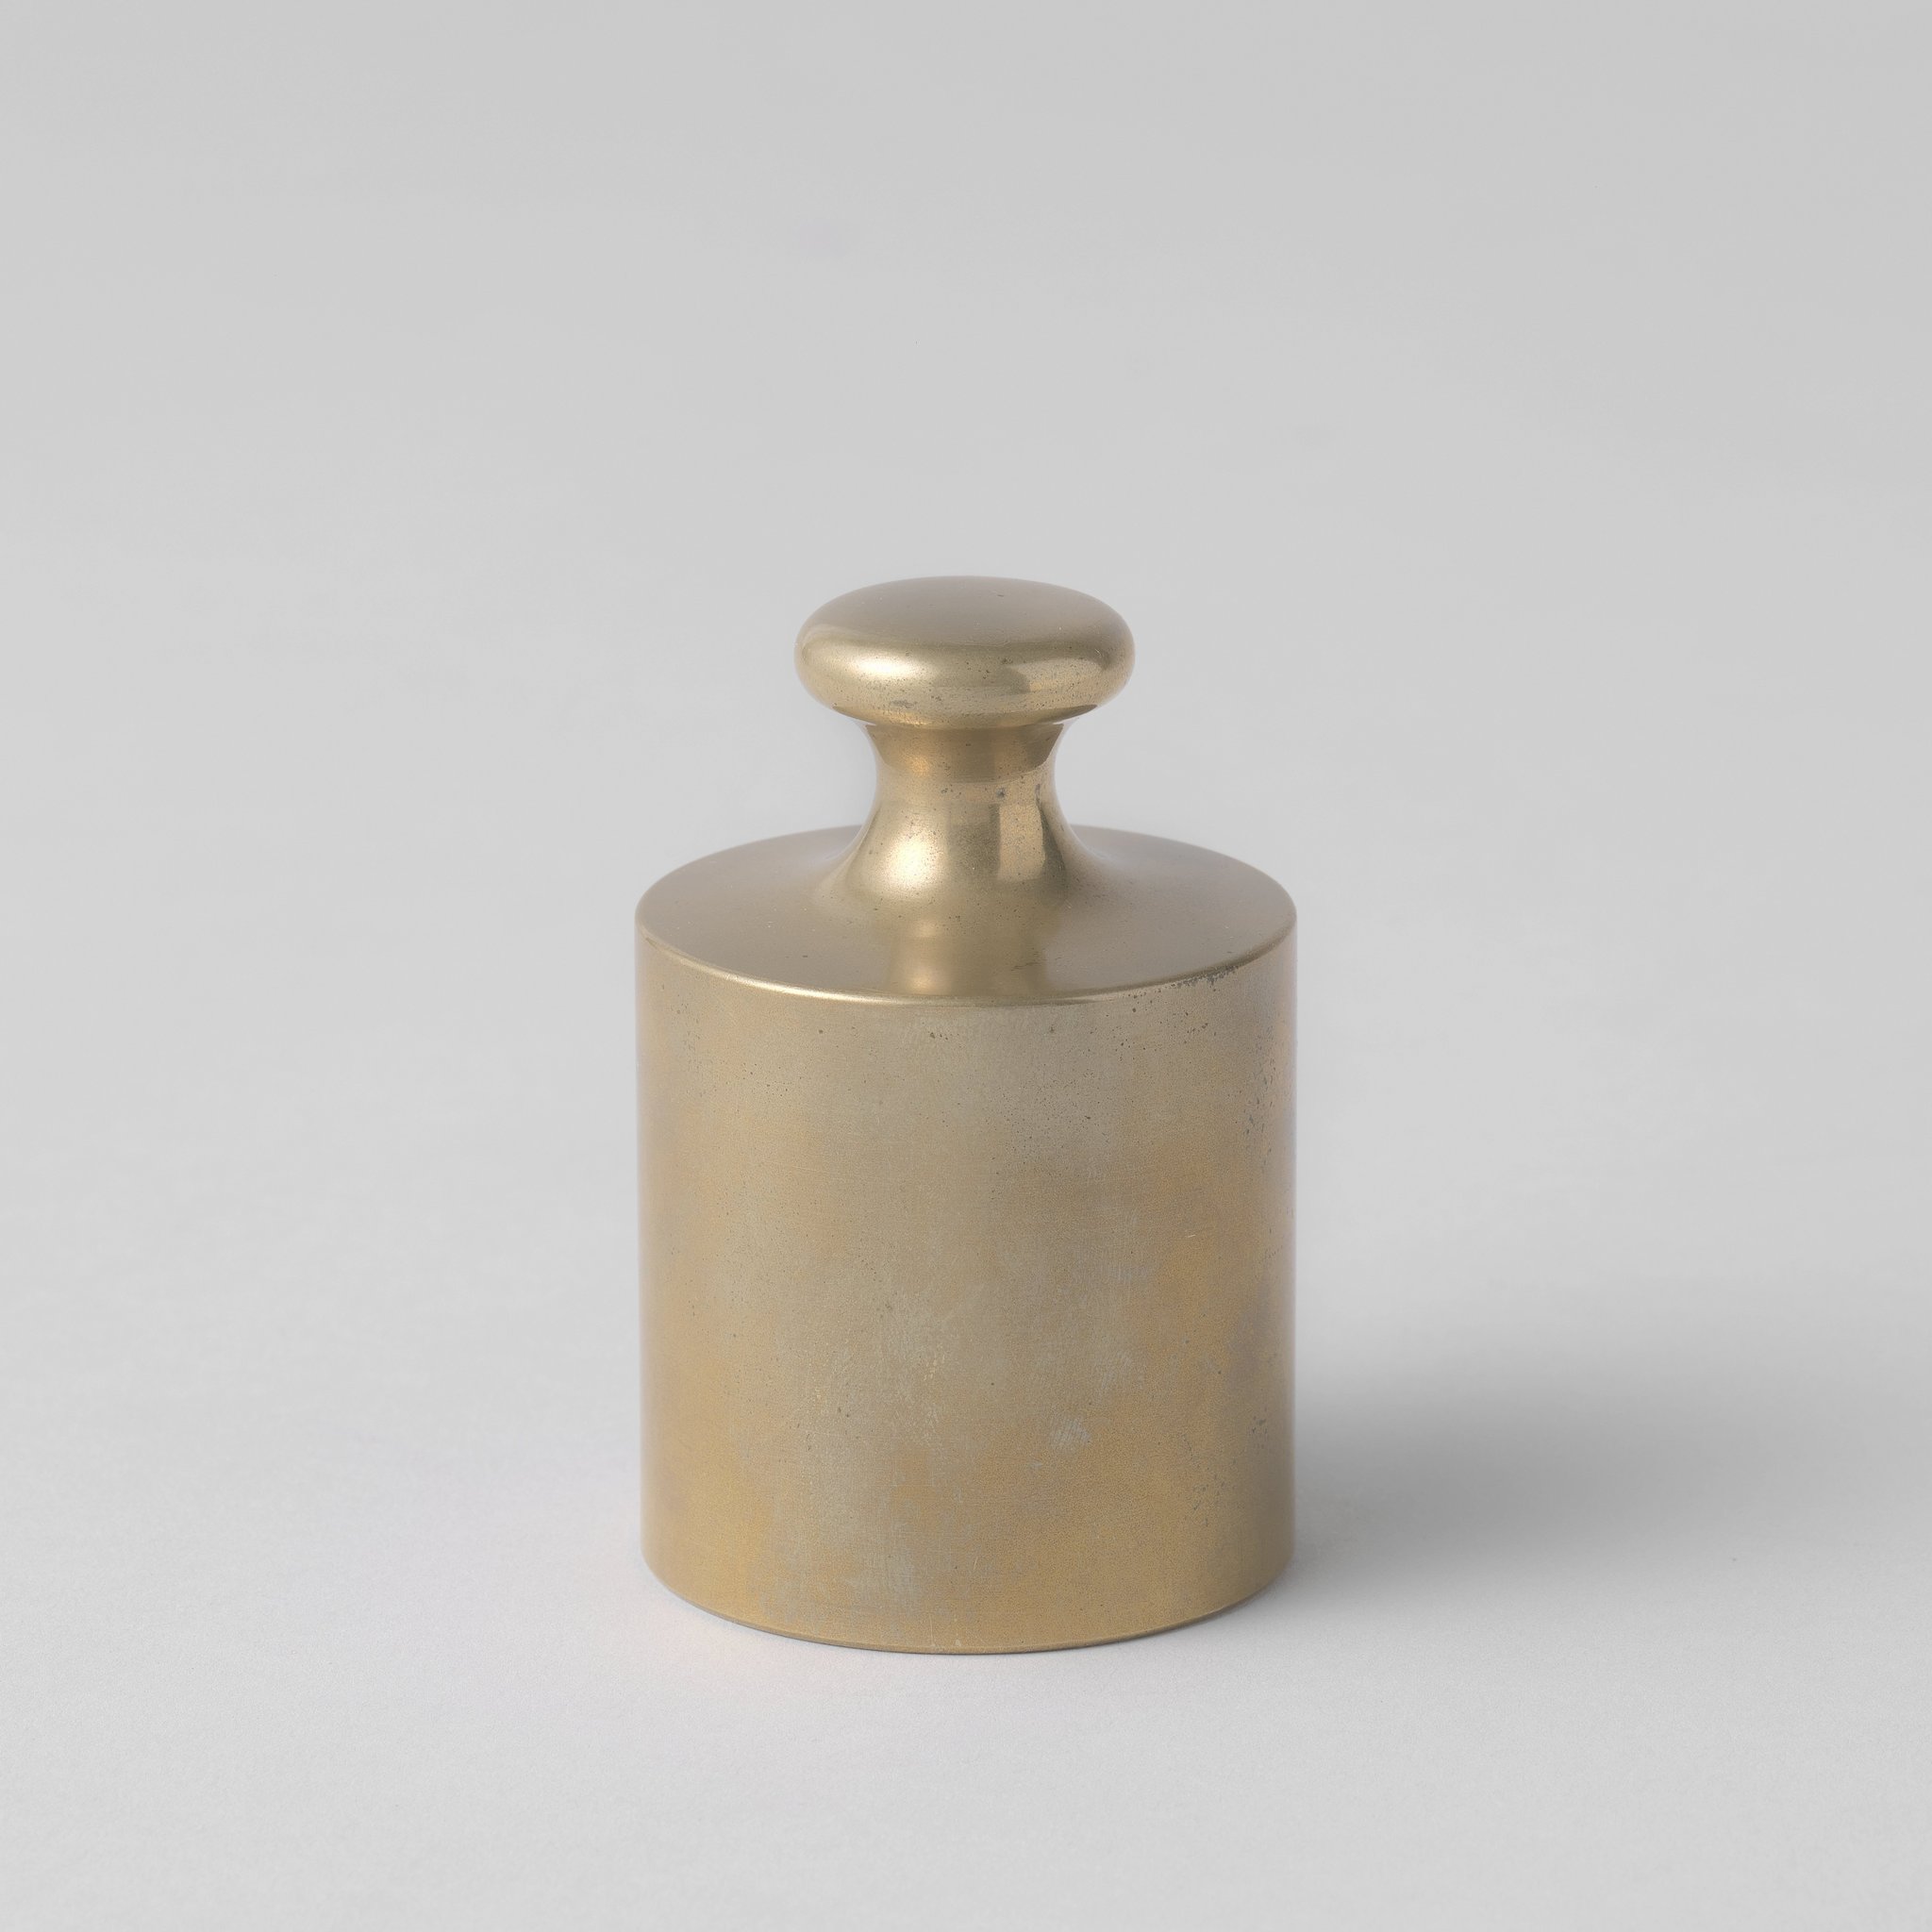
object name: box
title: Brass standard kilogram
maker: Anonymous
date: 1798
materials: brass, leather, velvet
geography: netherlands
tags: hendrik aeneae, the hague, amsterdam, jean henri van swinden, netherlands, paris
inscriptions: mark, inscription: ‘Kilogramme conforme a la loi du 18 Germinal an 3, présenté le 4 Messor an 7. Fortin F’, inscription: ‘L 10’, inscription: ‘Bij de vergelijking met den standaard N op 29 Nov. '9 bleek het kilogram 17,5 milligram te licht te zijn. / N.C. Kist’, inscription: ‘Deze Kologramme, zijnde de voormalige prototype welke tot in den jare 1939 bij de 1e Klasse van het Instituut berustende was, is op den 16 September 1847 door mij vergeleken met de nieuwe koperen prototype der kilogramme en bevonden 16 milligrammen ligter dan deze laaste te zijn. / R. Lobatto’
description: Prof. J.H. van Swinden en H. Aeneae, vertegenwoordigers van de Bataafsche Republiek op de Parijse Conferentie in 1798, waar de grondslagen van het metrieke stelsel werden vastgesteld, boden op 20 augustus 1799, namens het Nationaal Instituut van Frankrijk het Uitvoerende Bewind een ijzeren meter en koperen kilogram aan. Beiden gestempeld met het bijzondere merk van de Commissie van 1798. Dit exemplaar is niet in decimeters of in centimeters onderverdeeld, anders dan de exemplaren van Aeneae en Van Swinden zelf. De Parijse commissie wilde wel de precieze lengte van de meter garanderen, maar niet de onderverdeling. Dit gewicht werd tot standaard verklaard van het kilogram bij Kon. Besluit van 1 maart 1819, staatsblad no. 8. Art. 1 Tot eerste algemeene standaards of prototypen van de Nederlandsche Maten en Gewigten worden aangenomen: 1. ... 2. Onder den naam van Nederlandsch pond, de koperen kilogramme door dezelfde commissie gejusteerd en gestempeld, uit naam des Franschen Instituuts door gemelde gedeputeerden aan het Uitvoerend Bewind der Bataafsche Republiek op den 20 Augustus 1799 aangeboden en ook onder de eerste Klasse van het Koninklijk Nederlandsche Instituut berustende. Bij Kon. Besluit van 12 april 1839, Staatsblad no. 129, werd dit koperen gewicht als standaard vervangen door het platina kilogram.